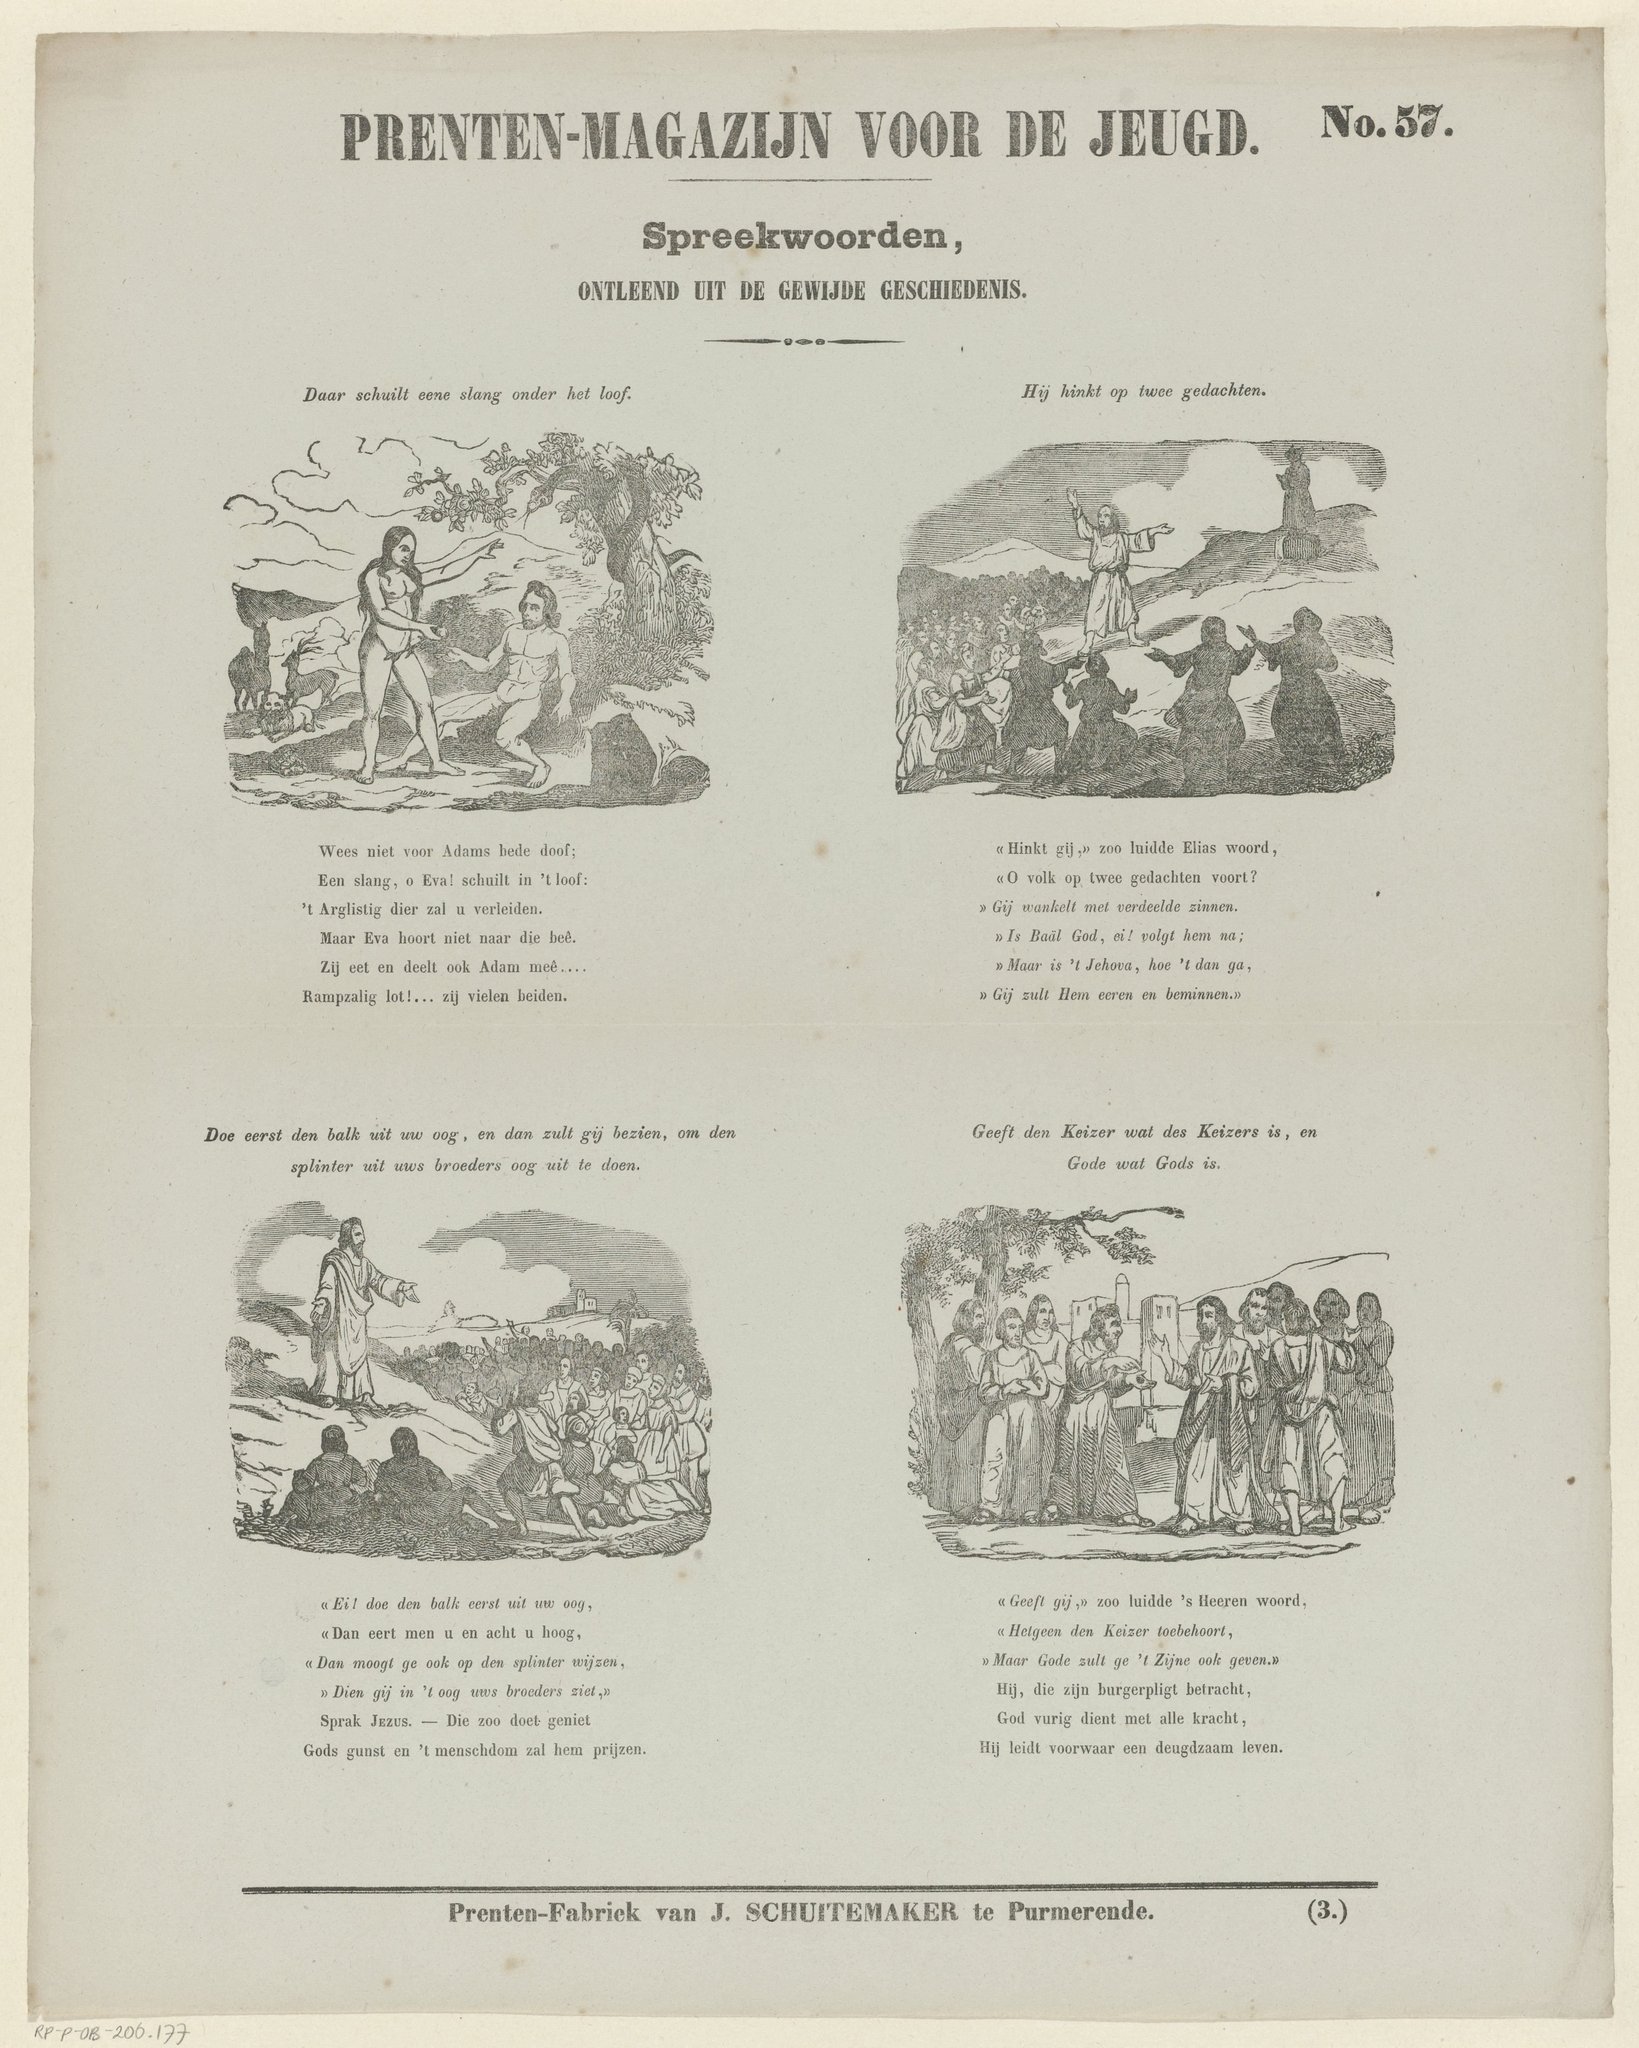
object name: print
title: Ontleend uit de gewijde geschiedenis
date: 1850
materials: paper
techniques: letterpress printing, engraving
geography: netherlands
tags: proverbs, sayings, etc., old testament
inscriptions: collector's mark: Lugt 2760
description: Na voltooiing van de acht jaargangen van de reeks 'Prenten-magazijn voor de jeugd' in 1850 heeft Jan Schuitemaker al deze prenten heruitgegeven en omgenummerd als nr. 1 t/m 192. De oorspronkelijke jaargang wordt telkens nog vermeld rechtsonder op de prent. Binnen de jaargangen zijn prenten van hetzelfde thema in clusters van vier achter elkaar gezet.